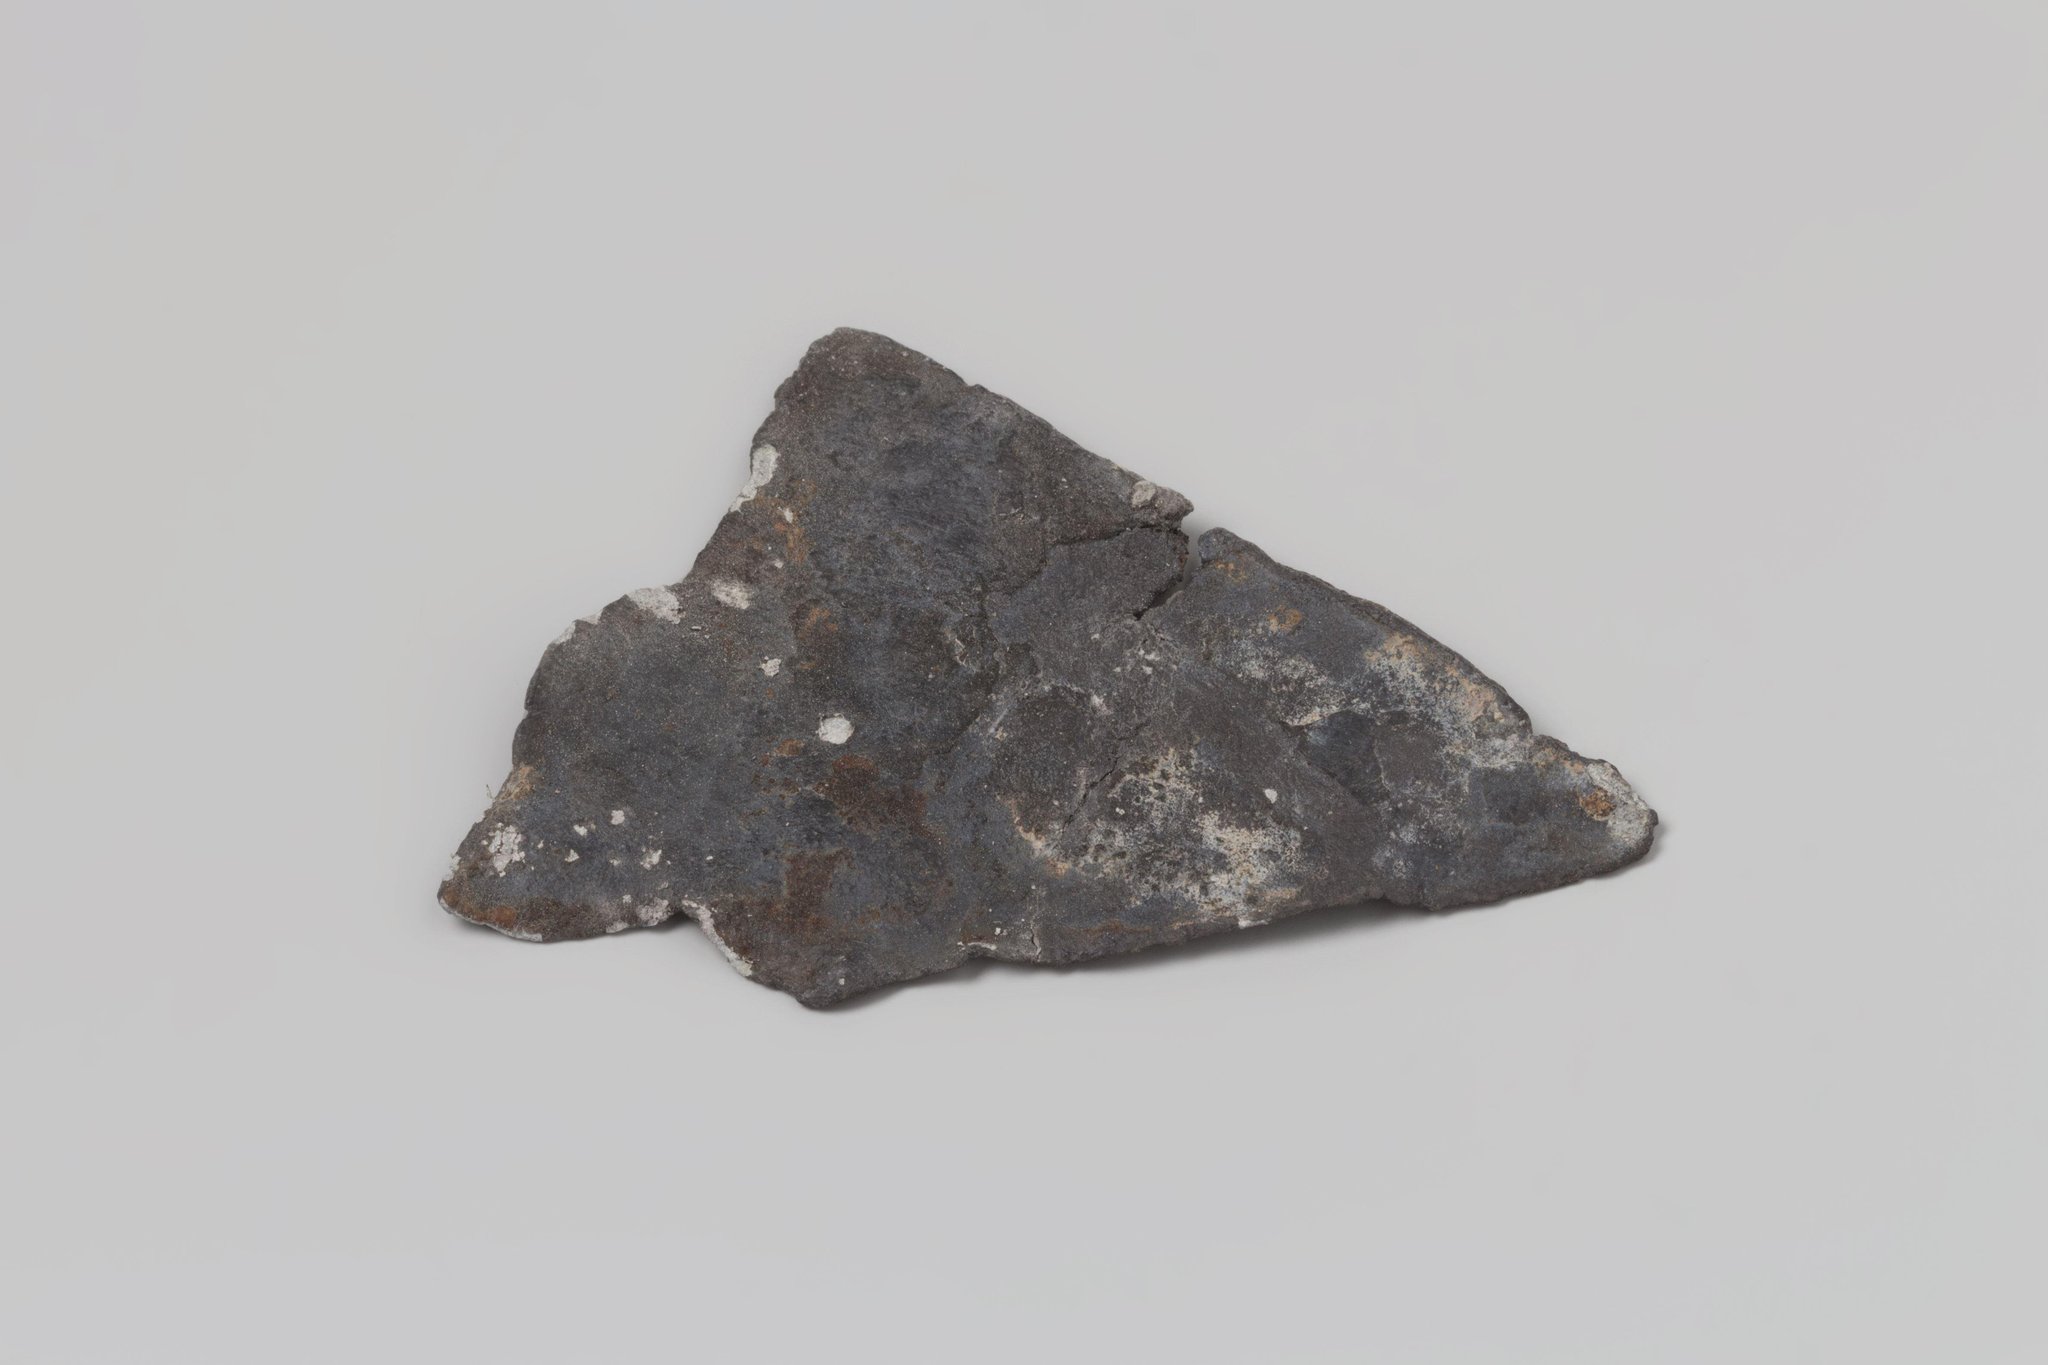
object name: sheet lead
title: Fragment van een loodplaat uit het wrak van de Oost-Indiëvaarder 't Vliegend Hart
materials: lead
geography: middelburg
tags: 't vliegend hart (schip), verenigde oostindische compagnie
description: Driehoekig stuk platlood, zonder gaten. Sheet fragments.